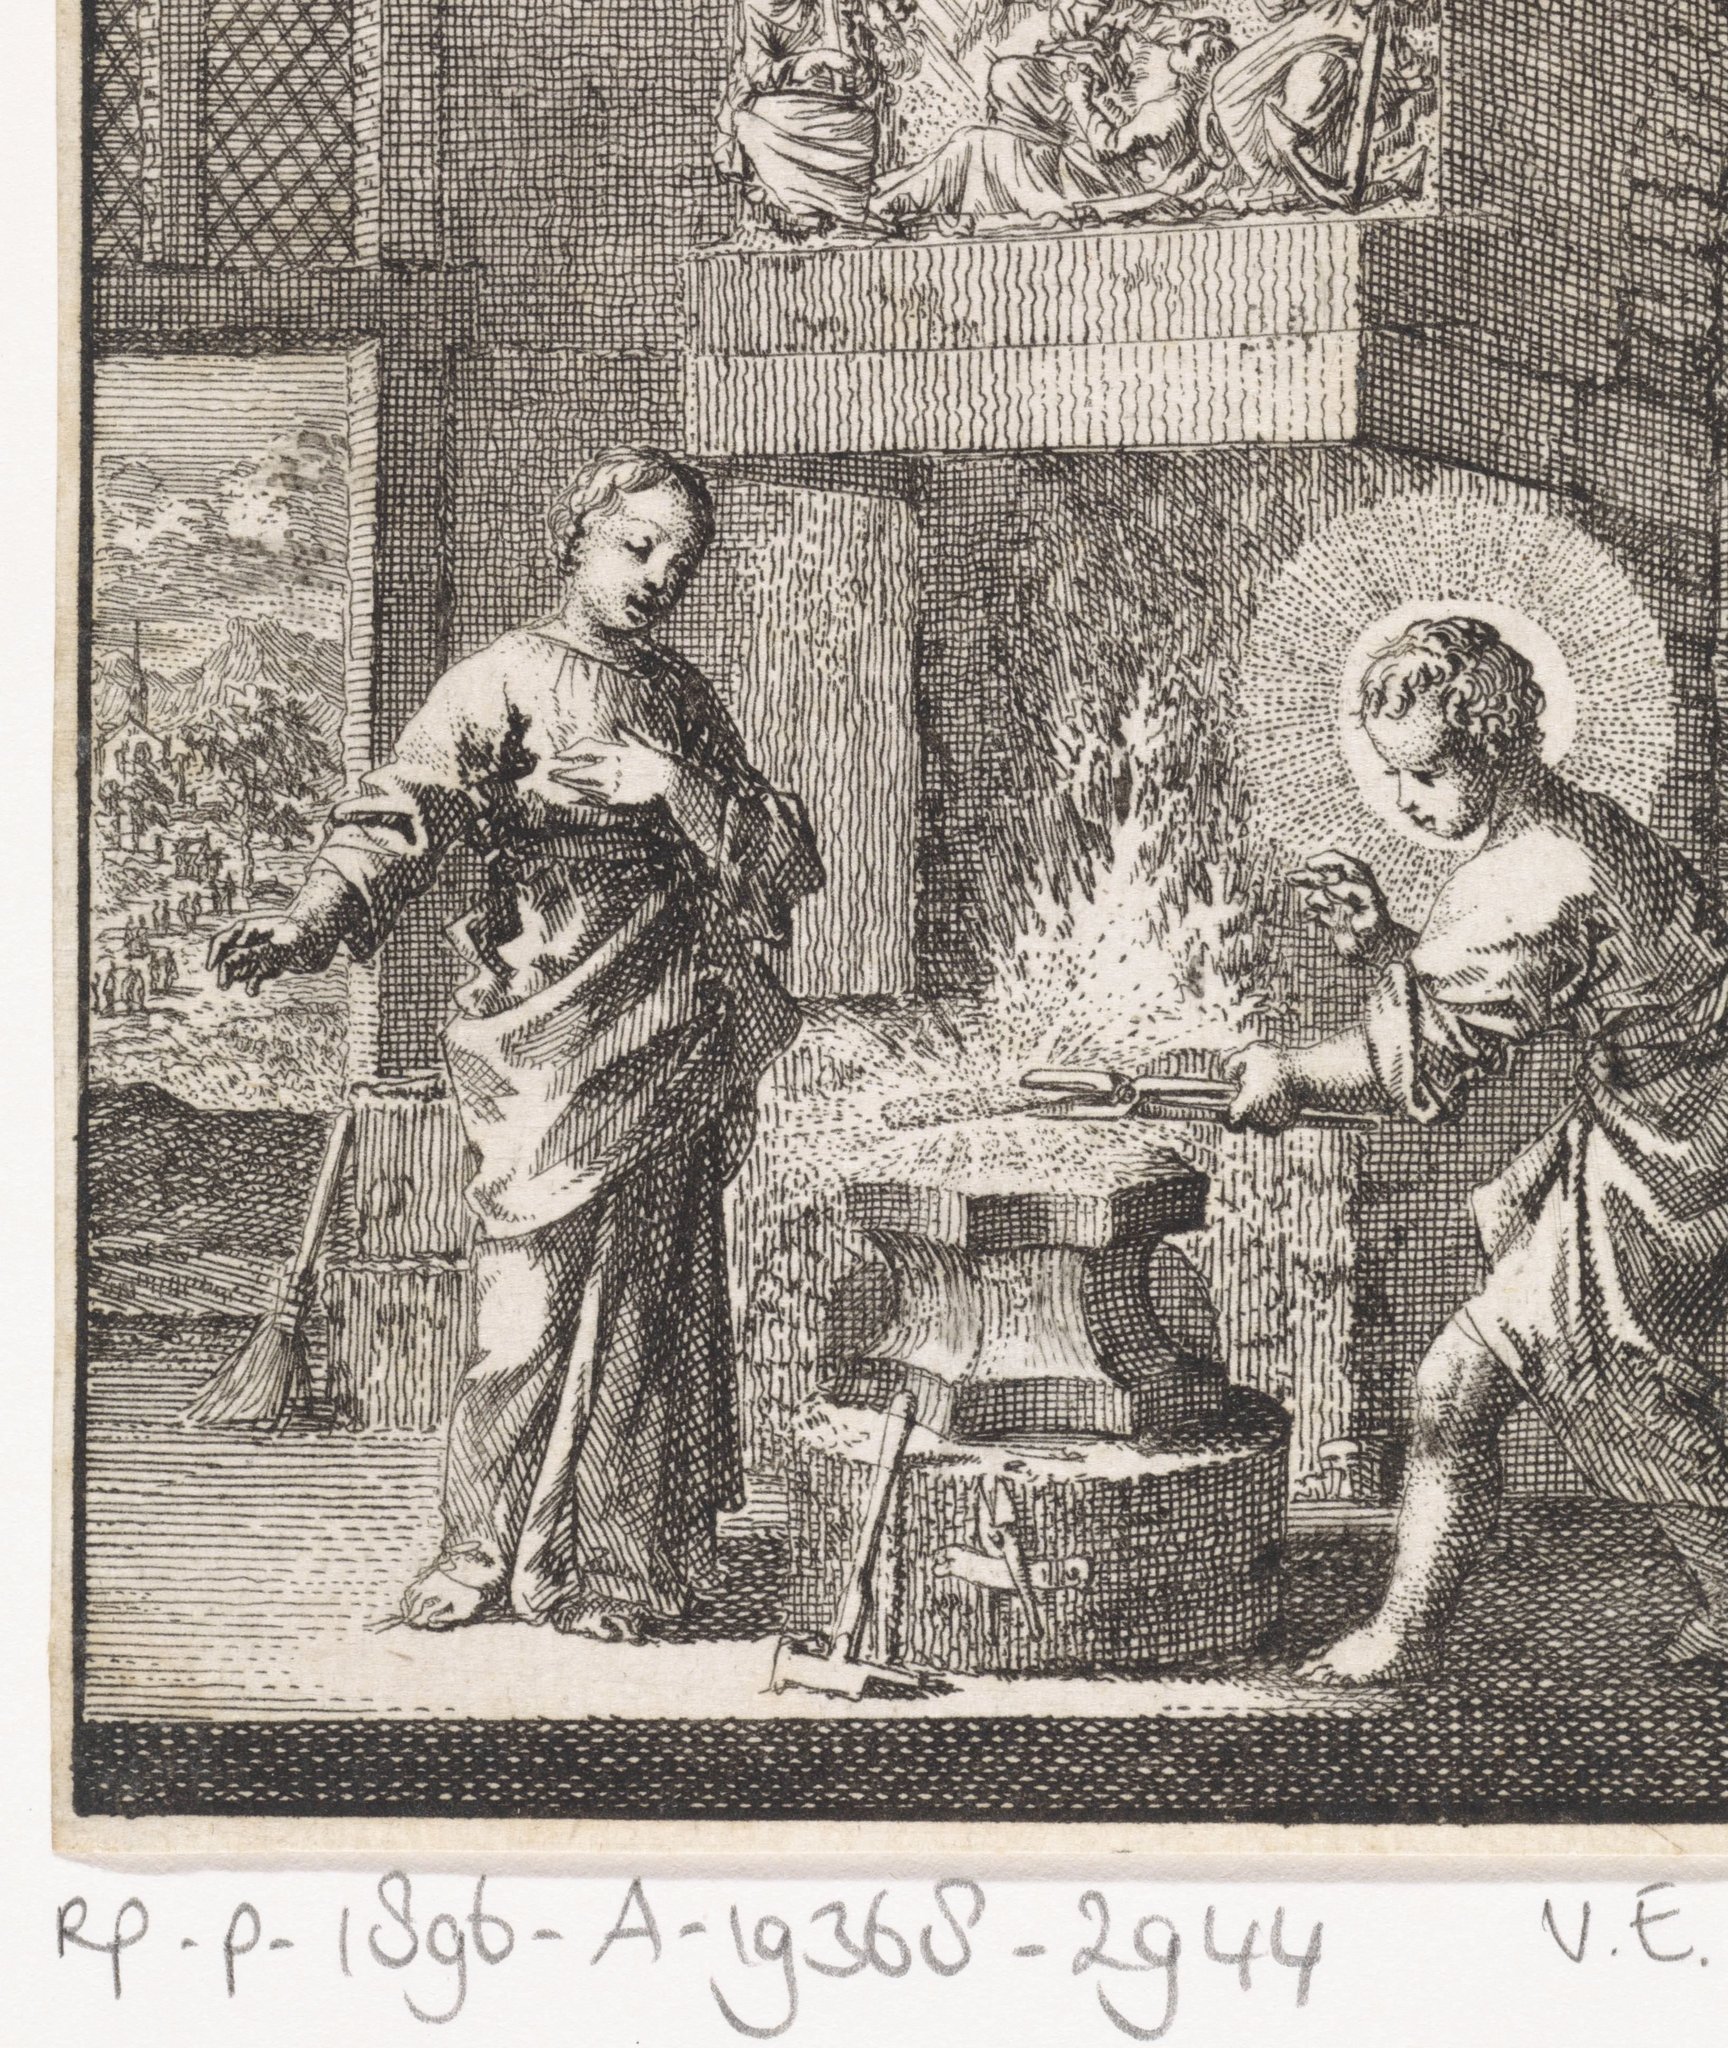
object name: print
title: Jezus en de Ziel in eene smidse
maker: jan luyken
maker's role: draughtsman, print maker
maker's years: 1649-1712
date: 1714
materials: paper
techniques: etching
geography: amsterdam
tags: smith, blacksmith (+ place ~ crafts, industries, agriculture), christ and the soul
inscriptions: collector's mark: Lugt 2228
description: Proefdruk van illustratie uit: Luyken, Jan. Jezus en de Ziel, 3 delen. Amsterdam: Wed. Pieter Arentsz II en Cornelis van der Sys, 1714, dl. II, p. 93.